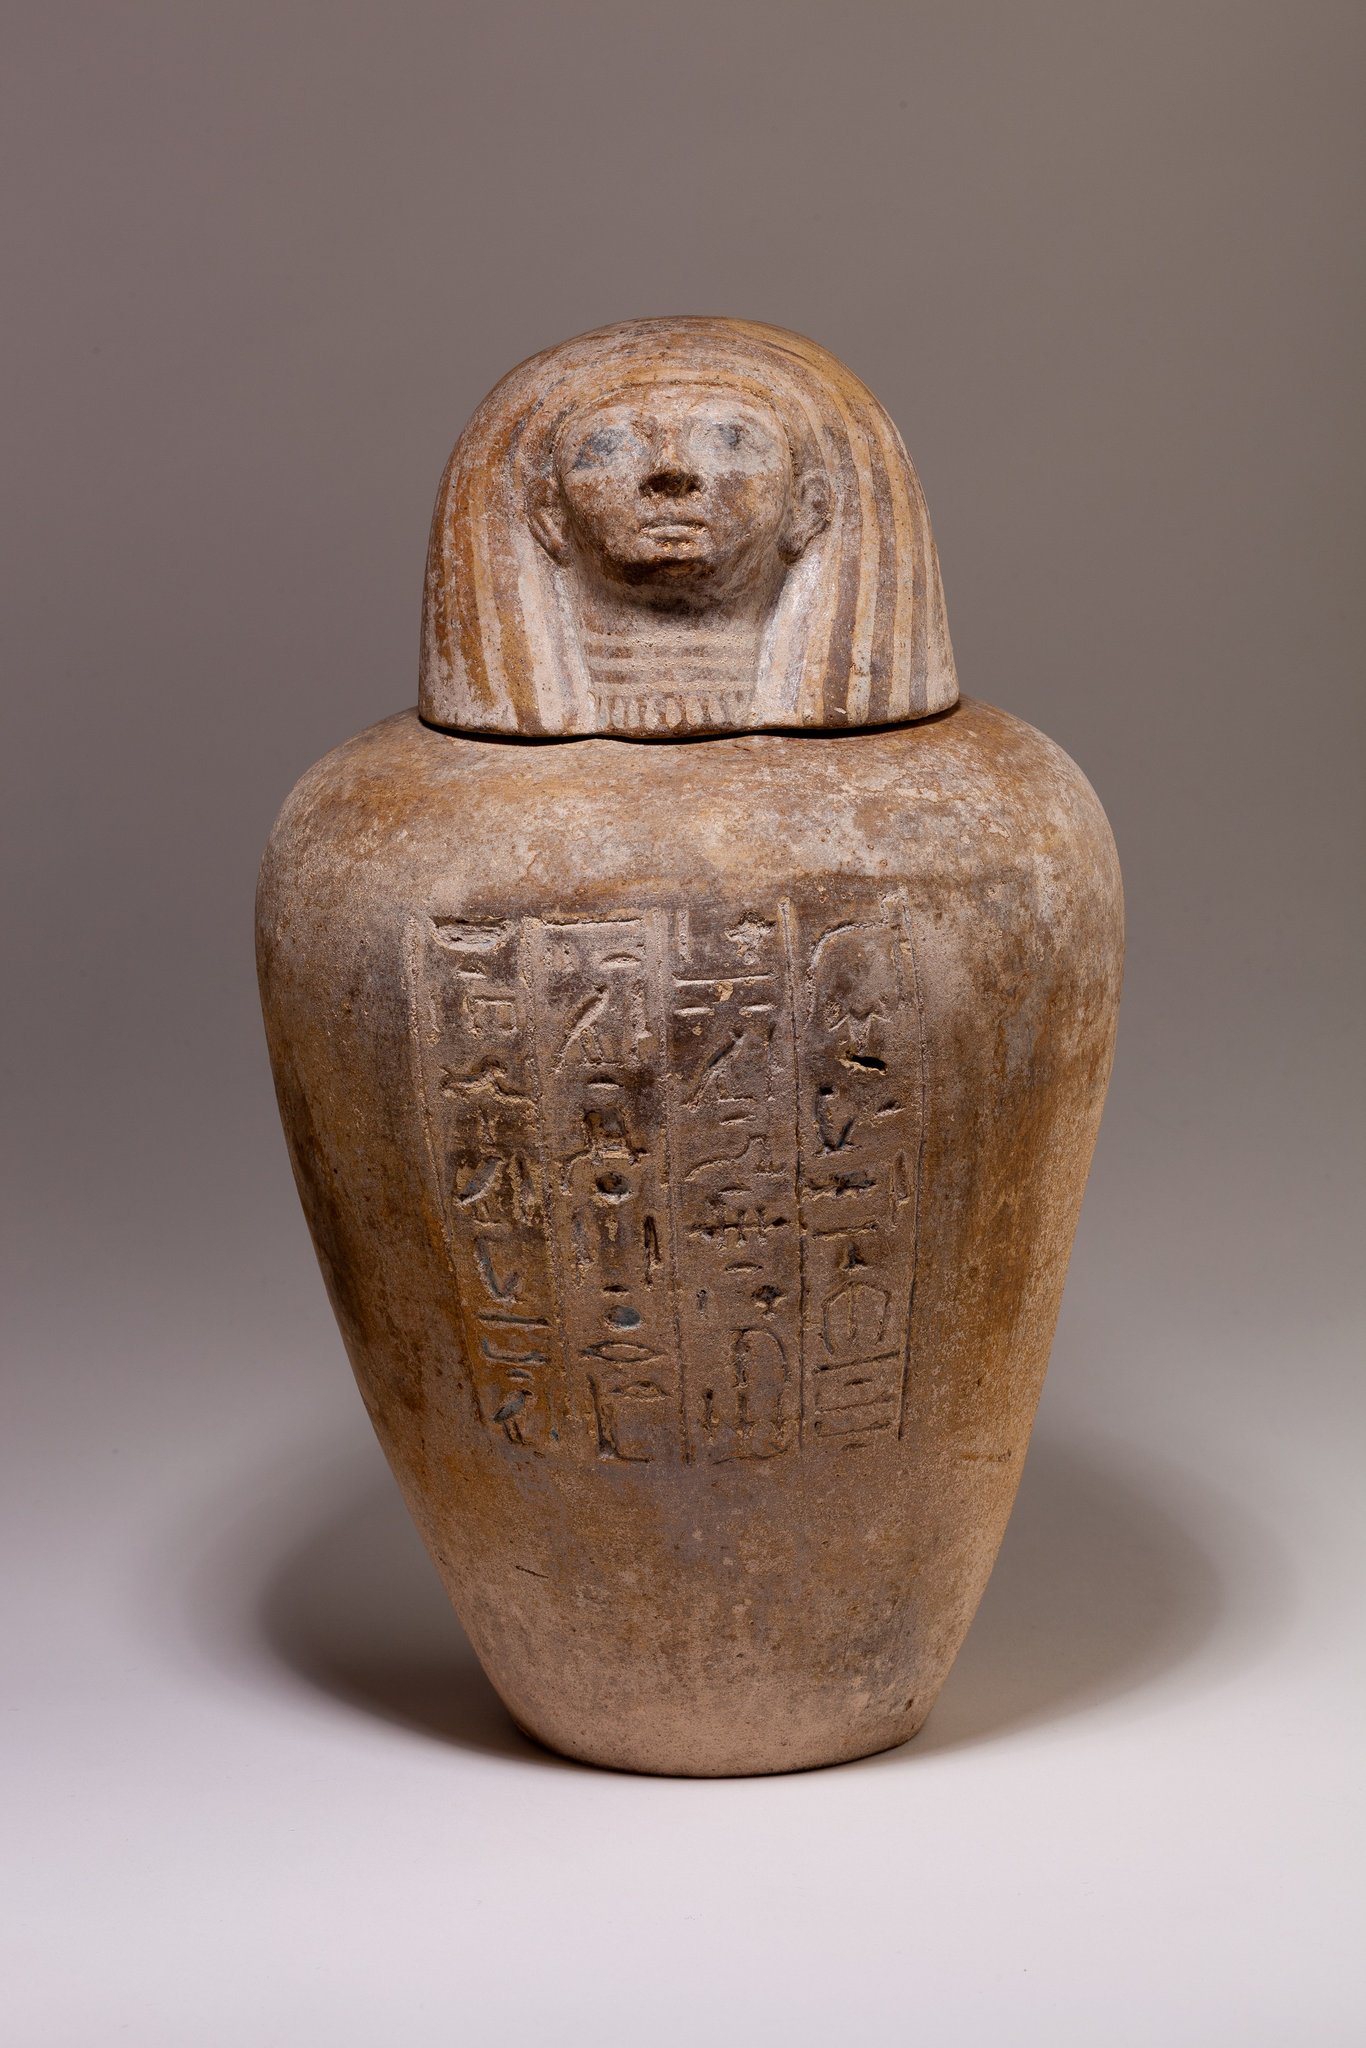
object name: canopic jar, ruiu, human head, hapy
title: Canopic Jar of Ruiu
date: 1504-1447 BCE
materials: paint, pottery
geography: egypt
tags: hieroglyphs